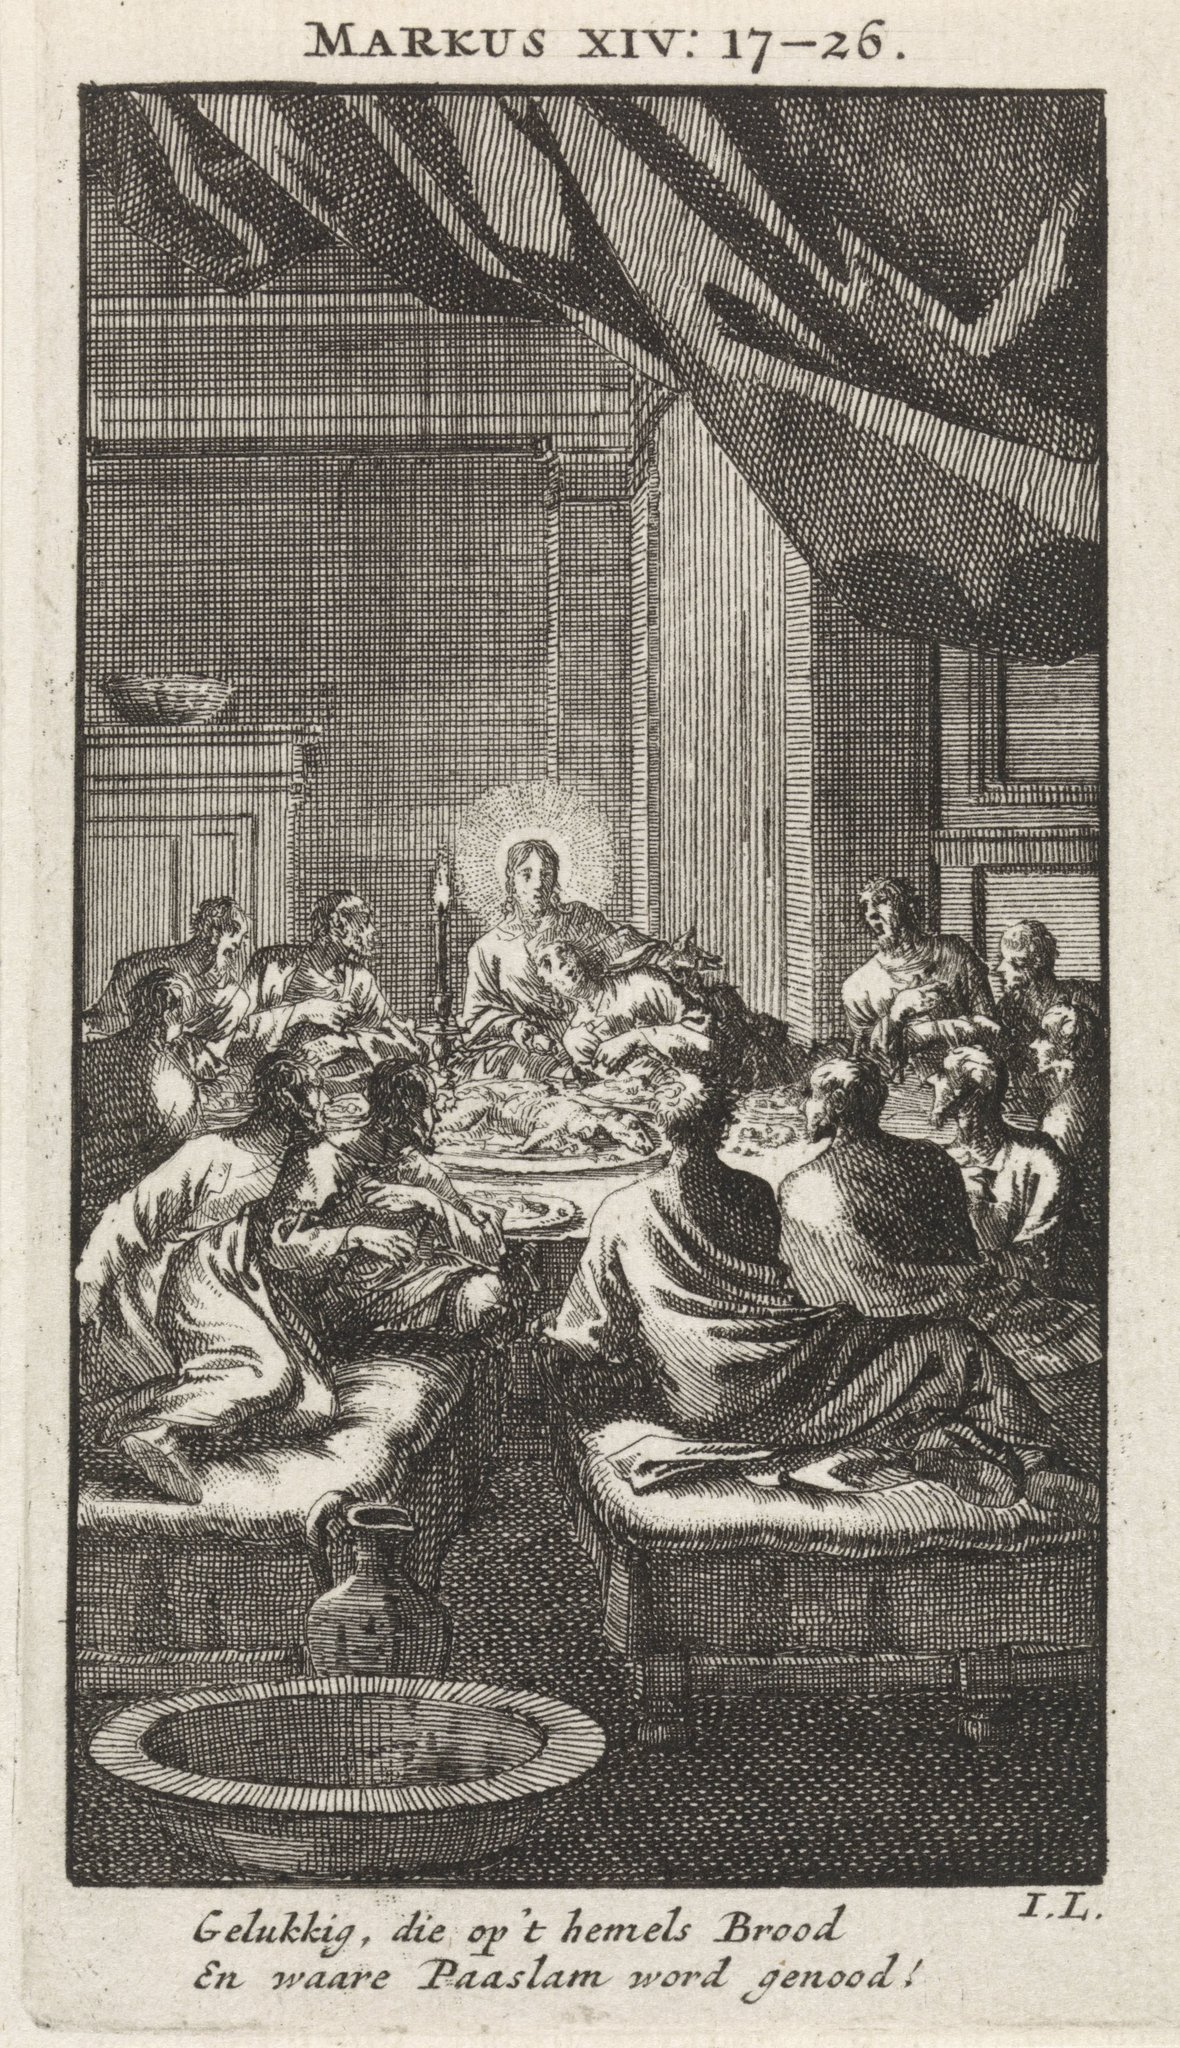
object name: book illustration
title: Laatste Avondmaal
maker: jan luyken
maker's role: draughtsman, print maker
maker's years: 1649-1712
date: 1712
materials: paper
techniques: etching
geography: amsterdam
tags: last supper (in general) (matthew 26:21-35; mark 14:18-31; luke 22:3, 22:15-23; john 13:21-38)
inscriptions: collector's mark: Lugt 2228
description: Illustratie voor: Luyken, Jan. Bybel printen. Amsterdam: Pieter Arentsz. II (wed.) en Cornelis van der Sys, 1712, p. 24.